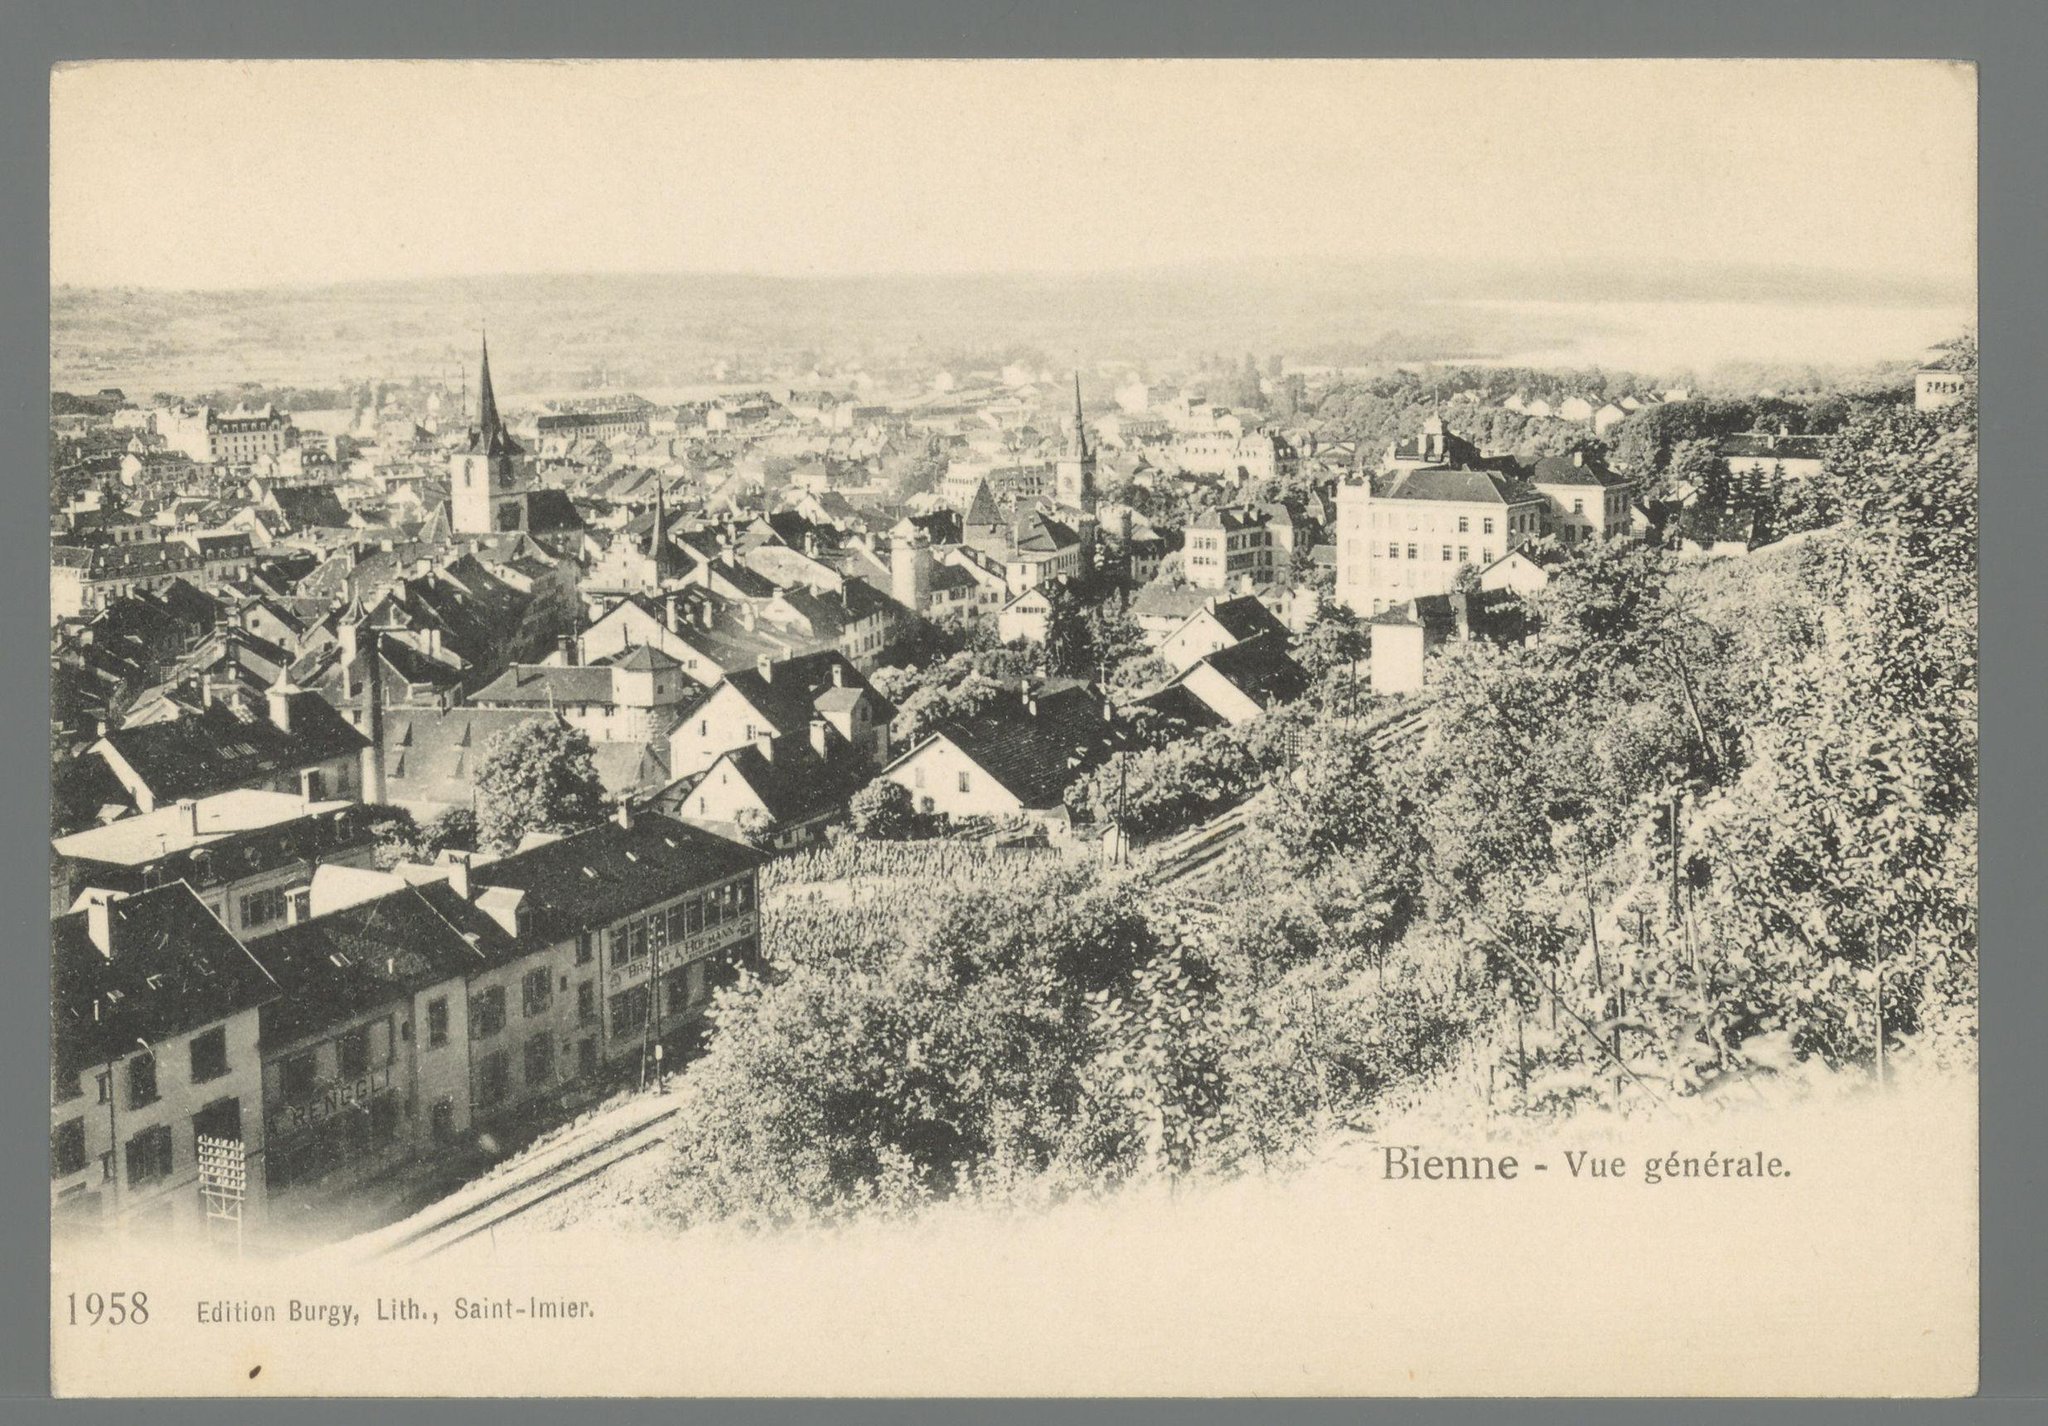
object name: ansichtkaart, prentbriefkaart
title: Bienne. Vue générale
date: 1890-1905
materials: cardboard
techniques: photograph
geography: saint-imier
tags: waterfall, lake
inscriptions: stamp